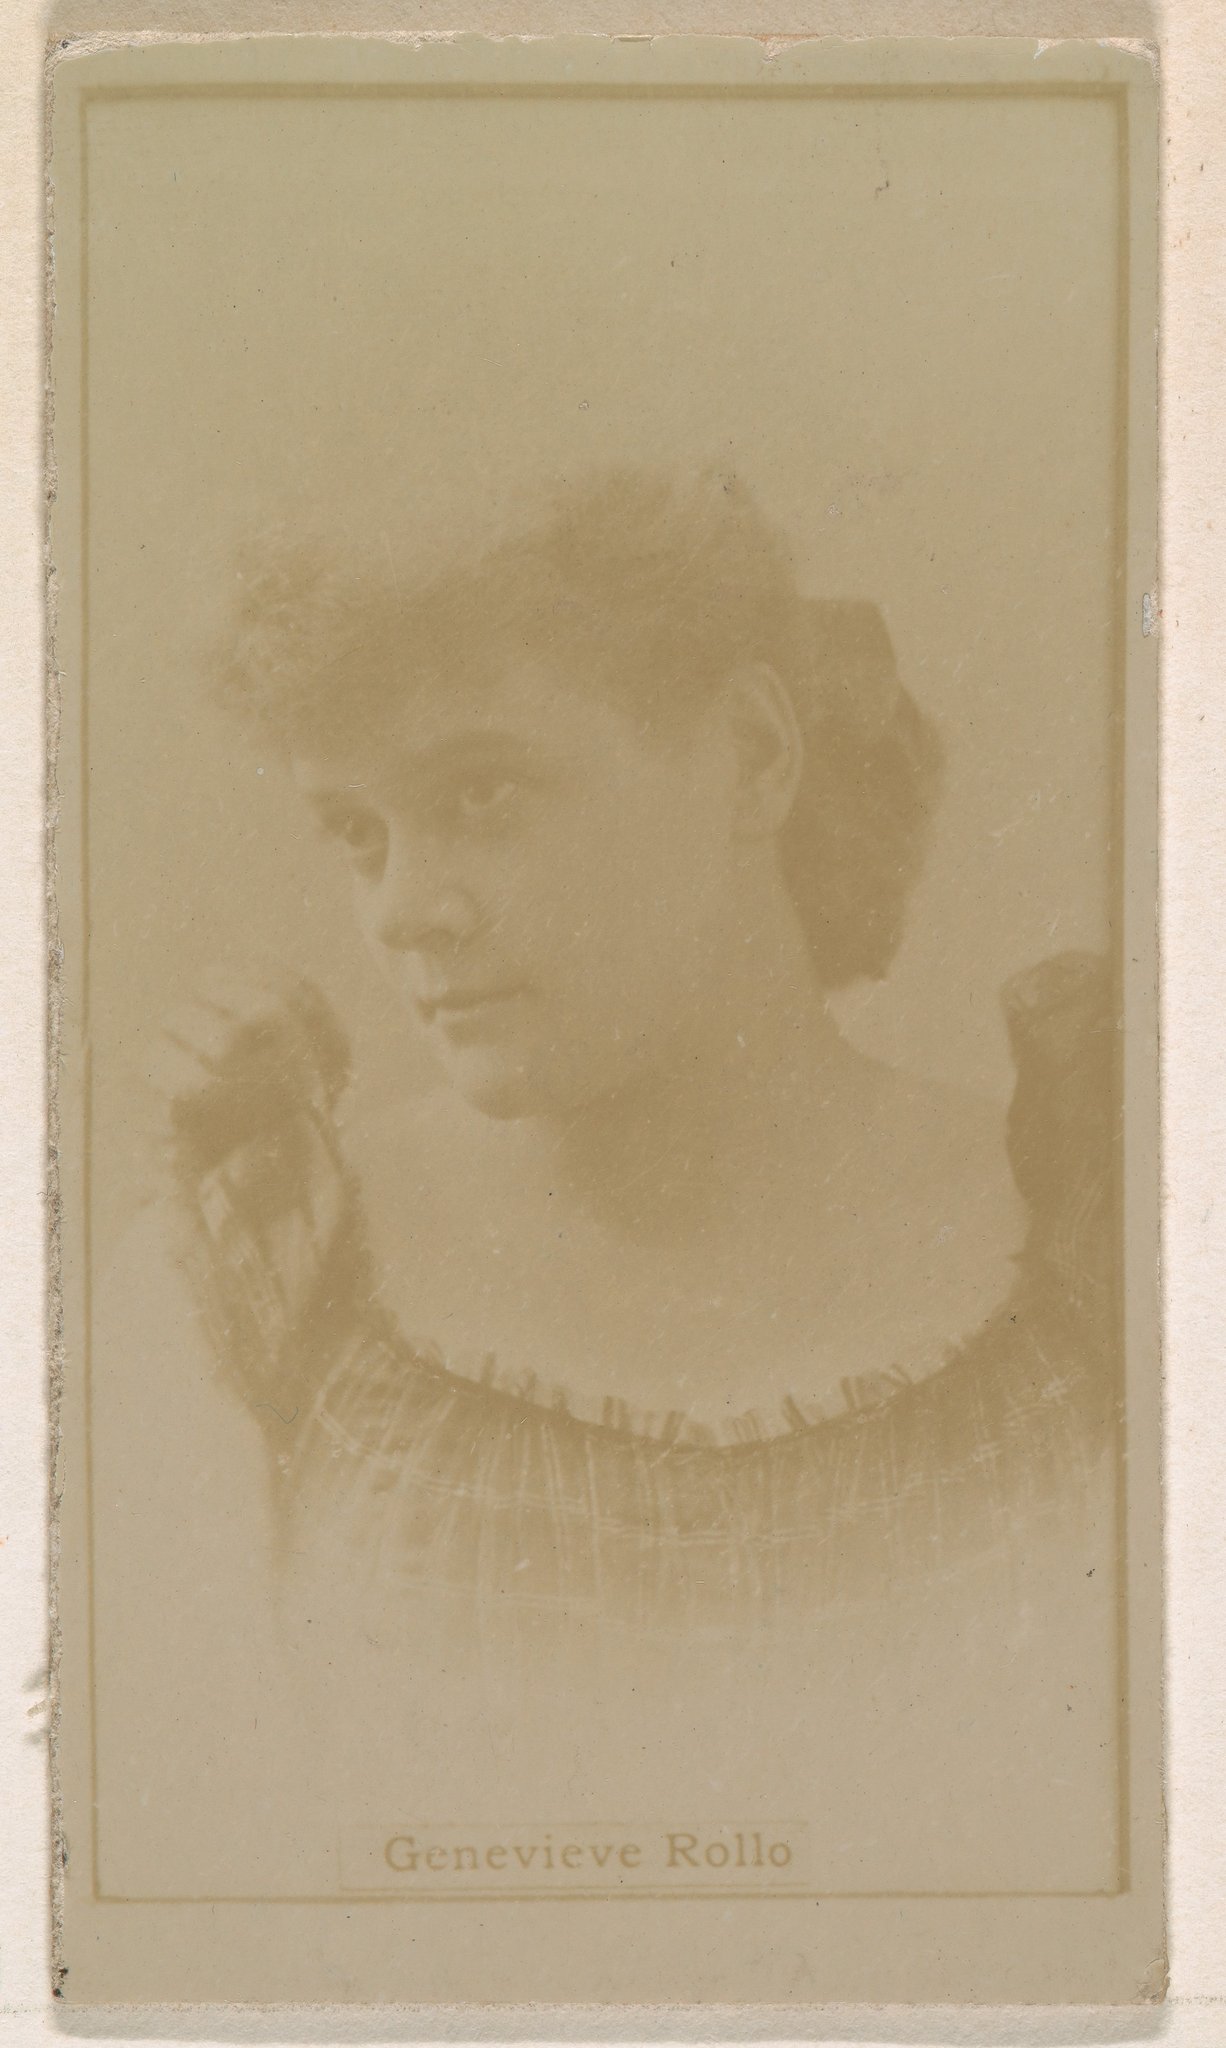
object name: photograph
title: Genevieve Rollo, from the Actresses series (N245) issued by Kinney Brothers to promote Sweet Caporal Cigarettes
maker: kinney brothers tobacco company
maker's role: publisher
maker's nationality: american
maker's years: 1869-2011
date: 1890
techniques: albumen silver print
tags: portraits,women,actresses